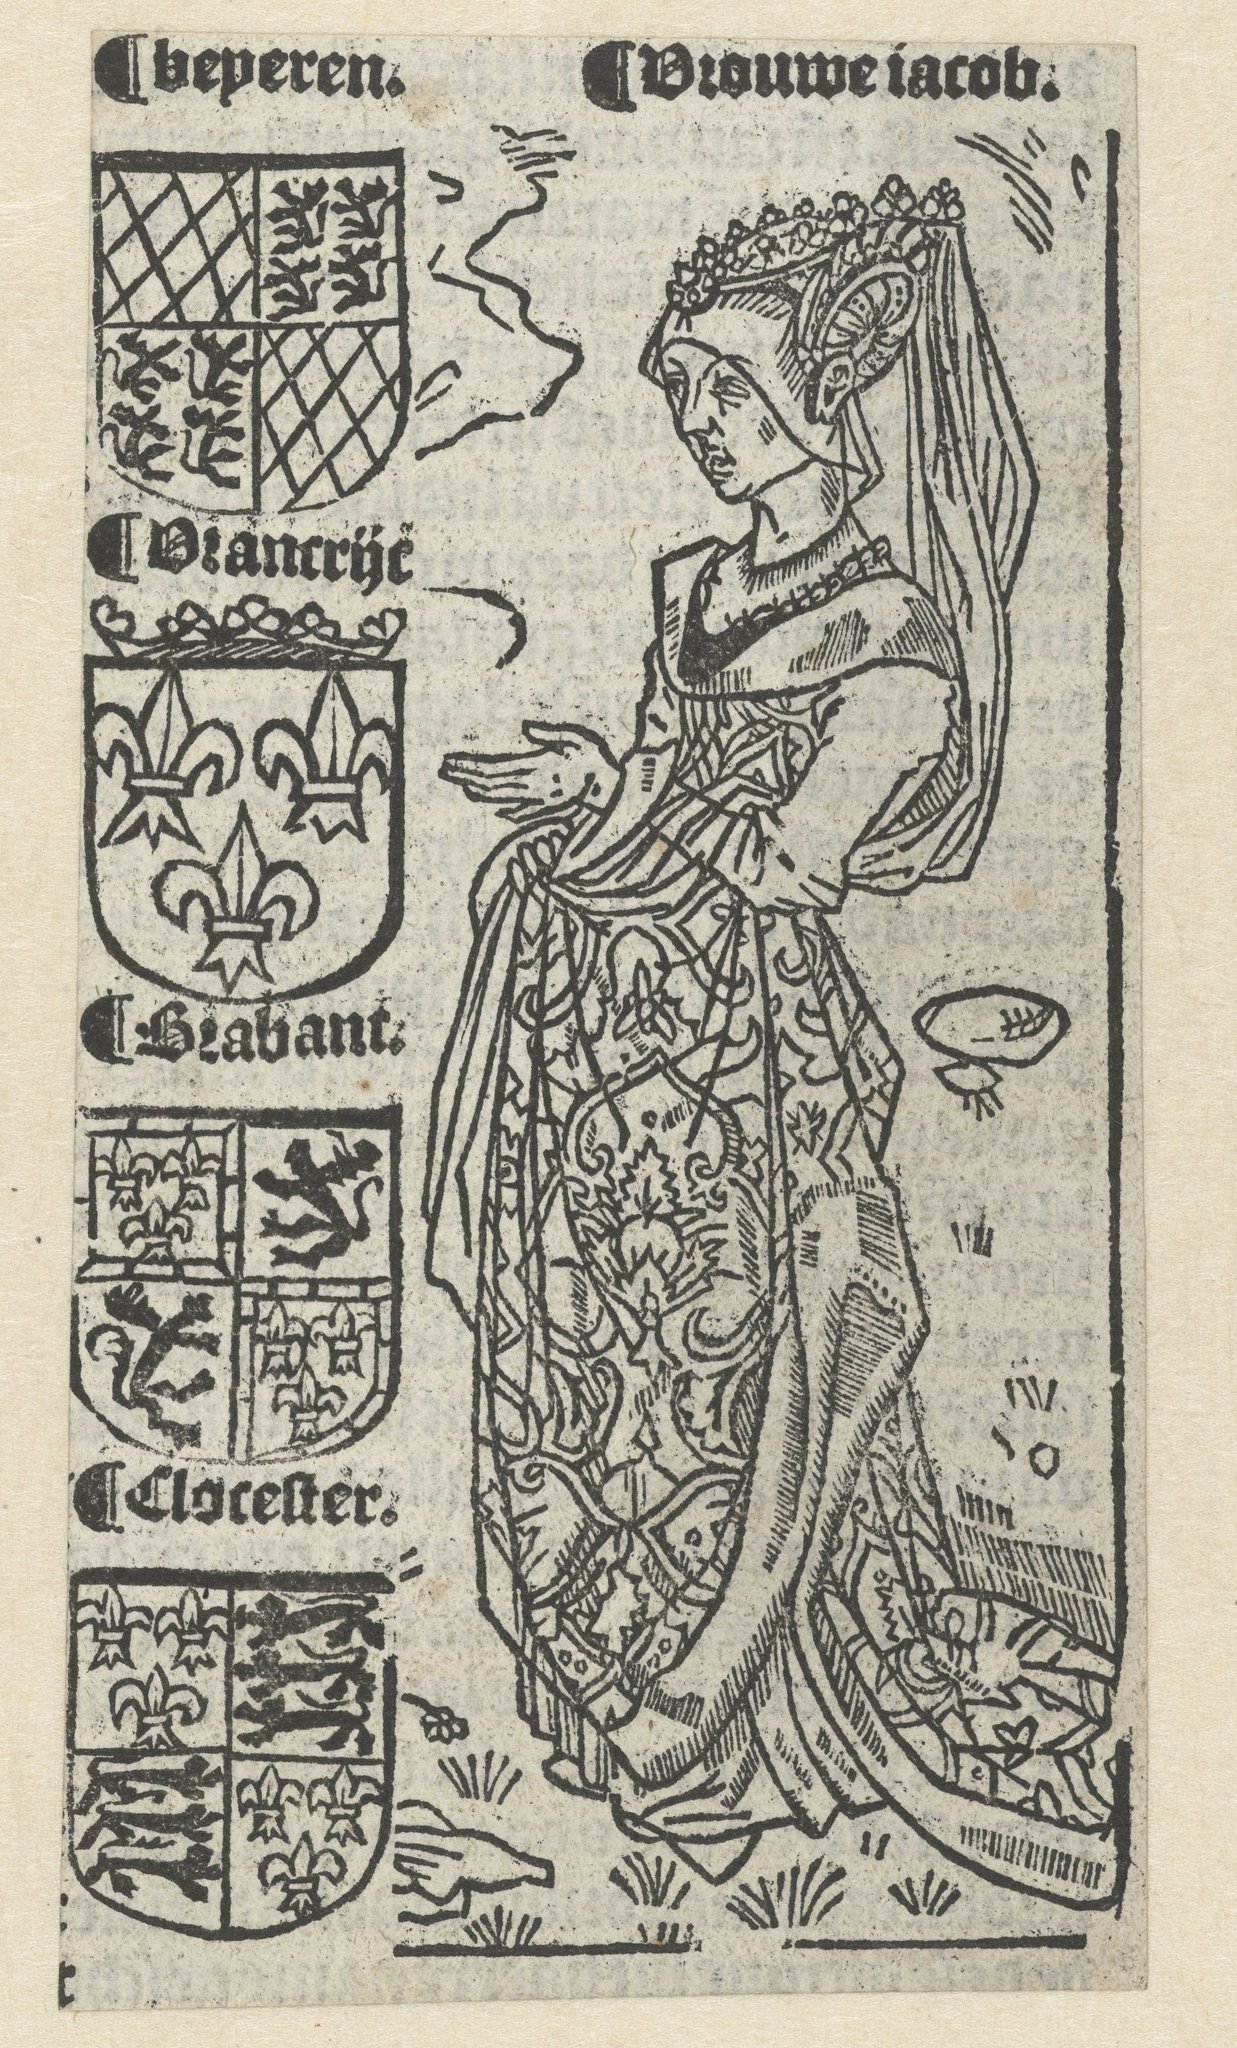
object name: book illustration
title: Vrouwe jacob.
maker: Anonymous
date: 1517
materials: paper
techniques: woodcut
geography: low countries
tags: jacoba of bavaria (countess of hainaut), veil (+ women's clothes), head-gear: hat (+ women's clothes), dress, gown (+ women's clothes), (scenes from) specific works of literature (with author, title)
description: Late afdruk van de versneden houtblokken van Le Chevalier déliberé van Olivier de la Marche (Gouda 1486). Eén blad van veertien uit Cronycke van Hollandt, uitgegeven door Jan Seversz, te Leiden in 1517 en 1530. Uit blad 15.